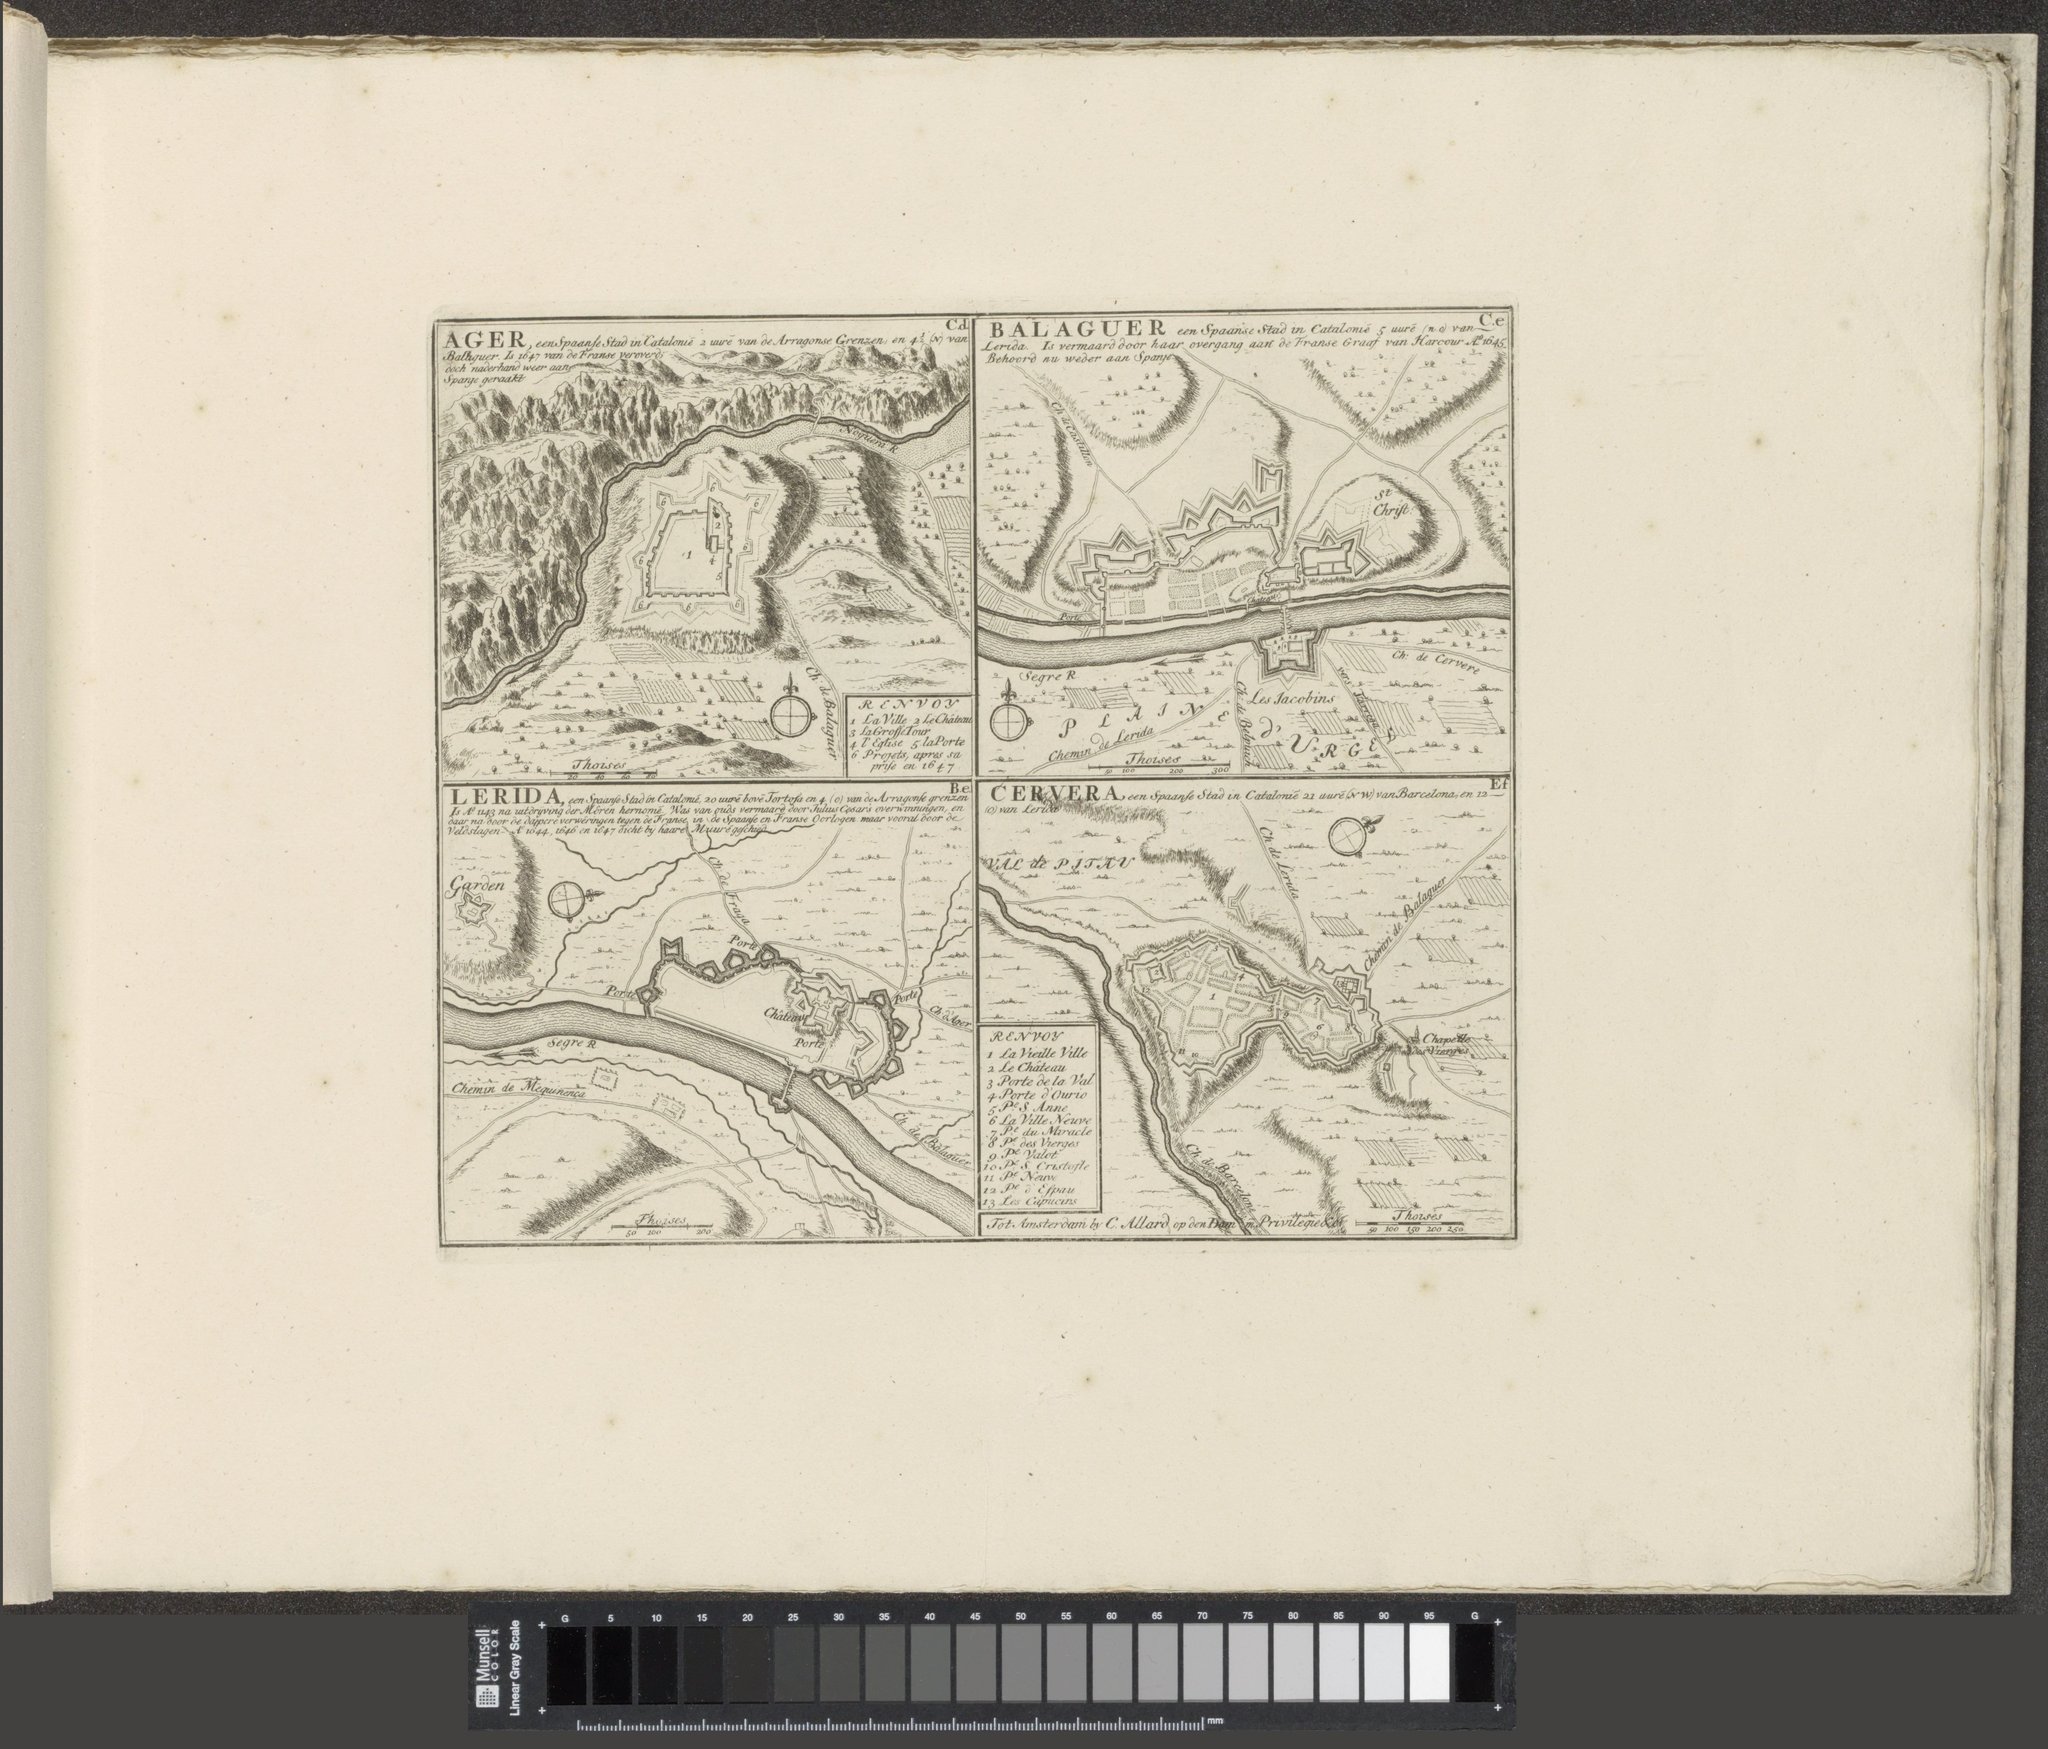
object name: map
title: Àger en andere steden in Catalonië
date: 1701-1733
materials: paper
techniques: etching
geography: leiden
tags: fortifications, military engineering, maps of cities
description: Voorstelling met vier kaarten van steden in Catalonië. Met teksten in het Nederlands en Frans. De prent maakt deel uit van een album.